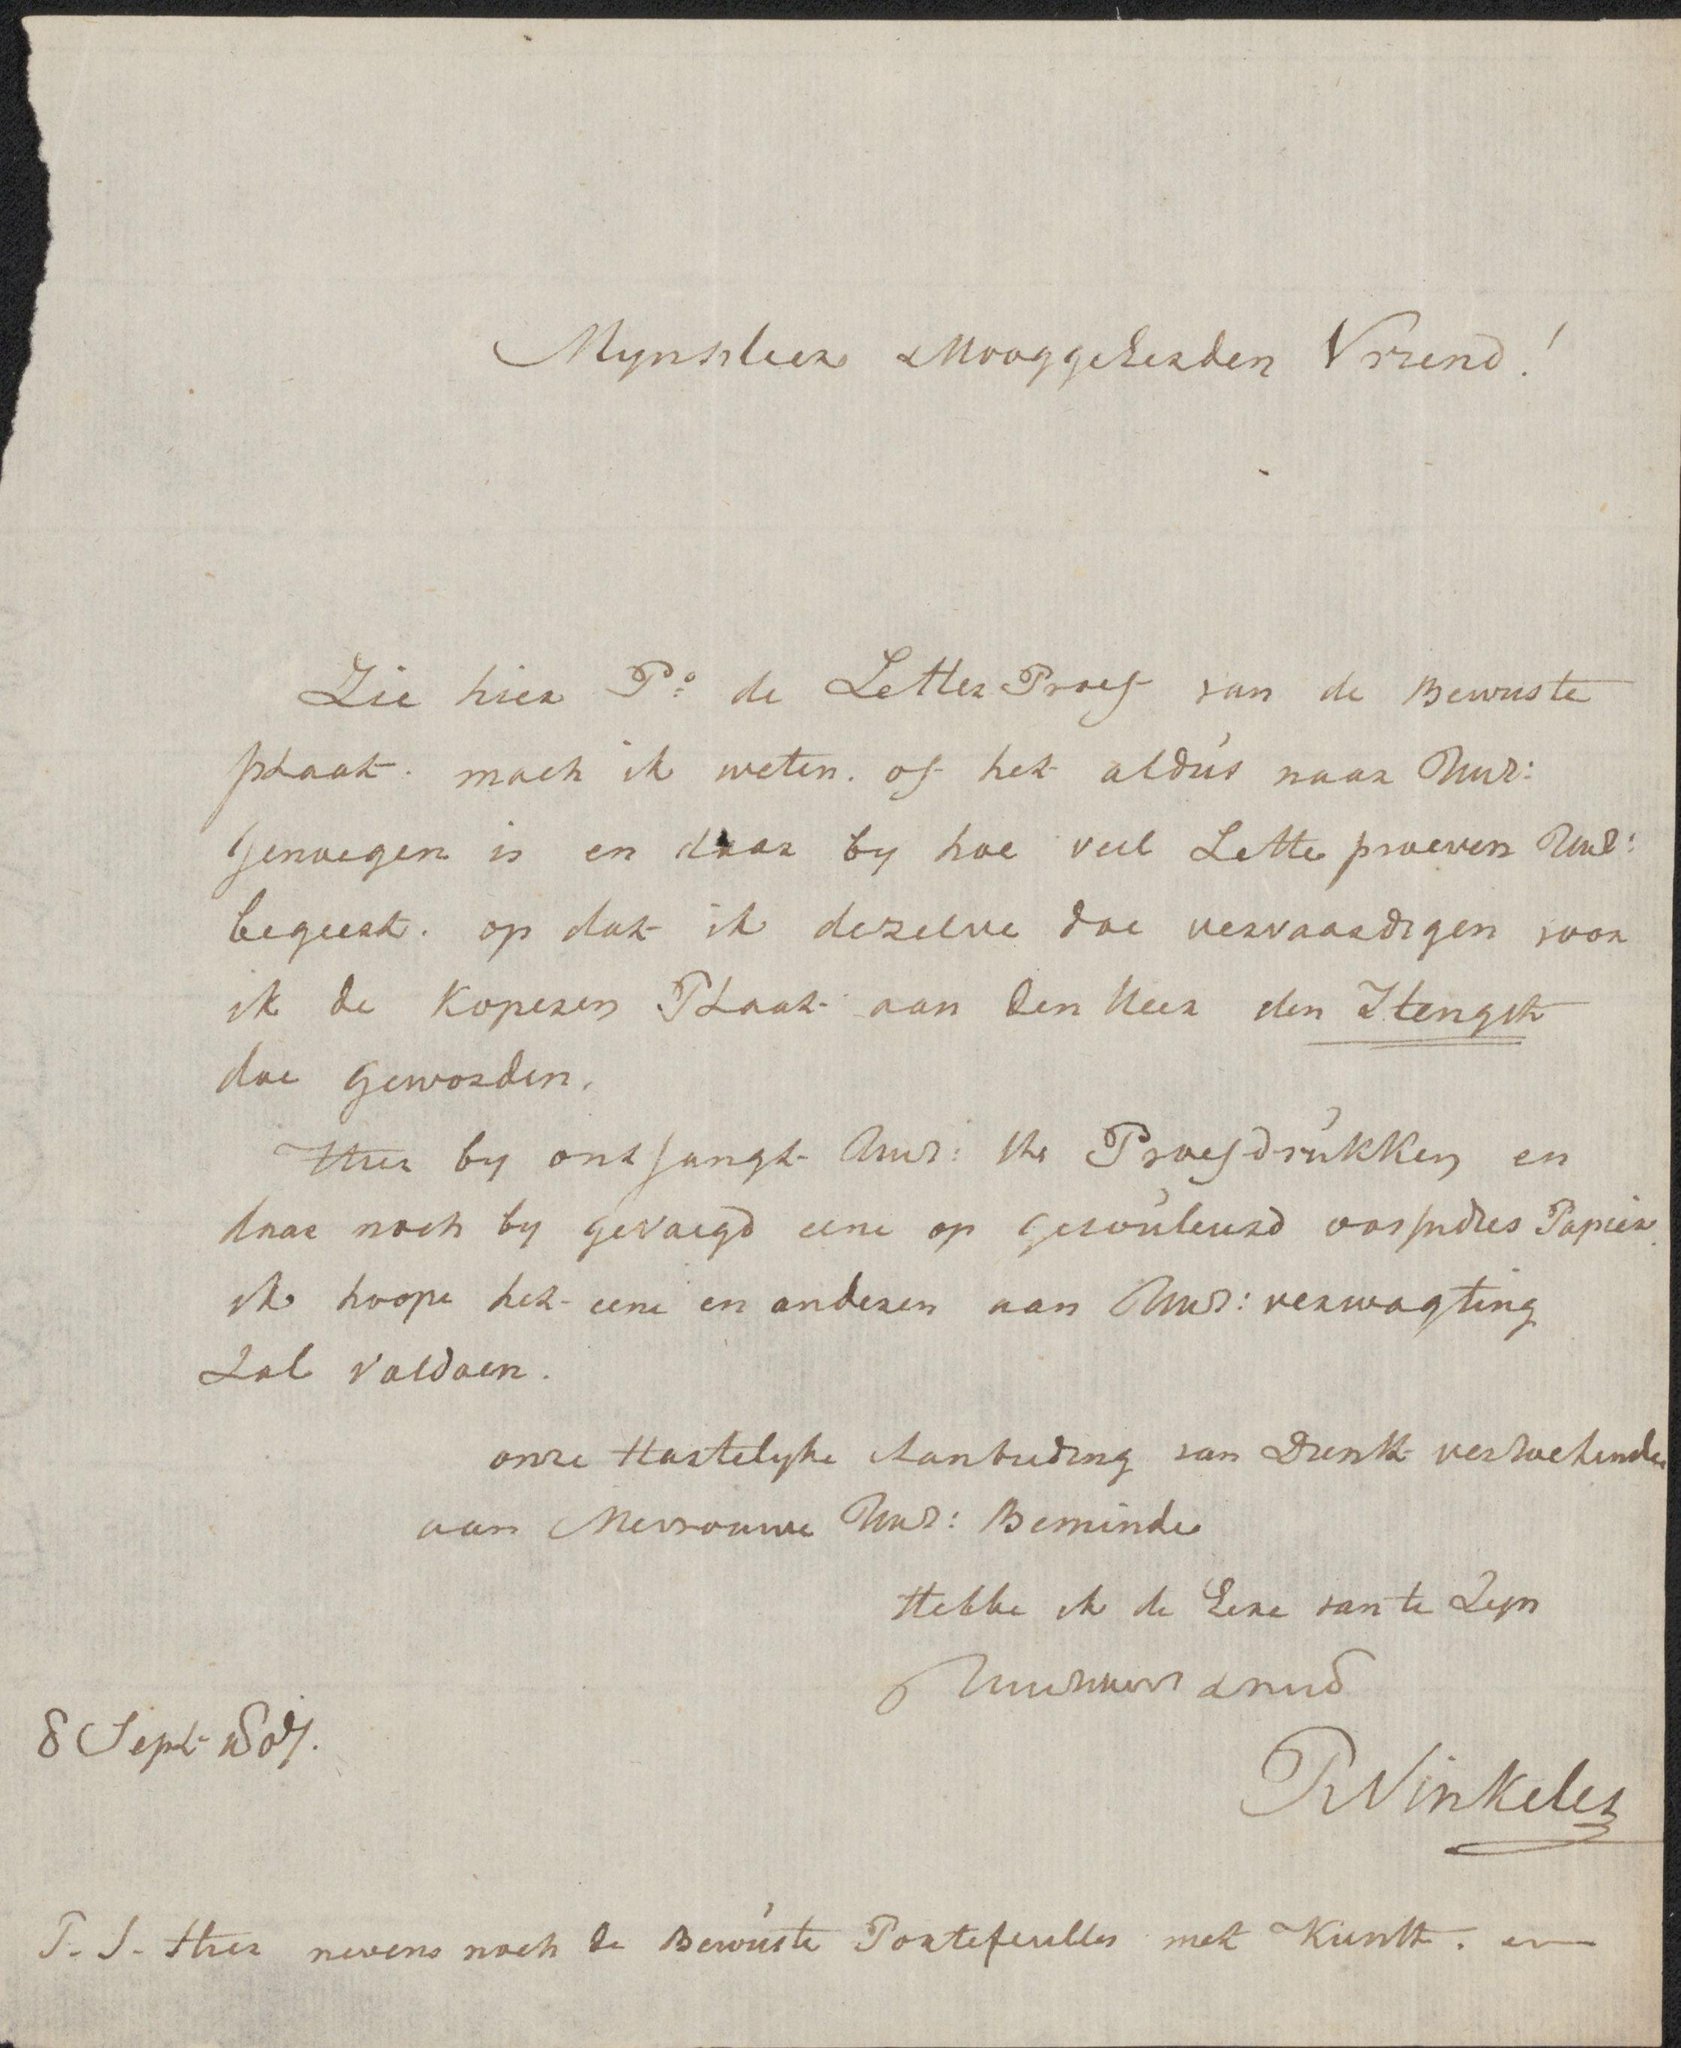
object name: letter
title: Brief aan anoniem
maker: reinier vinkeles (i)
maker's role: draughtsman, print maker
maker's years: 1741-1816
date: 1807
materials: ink, paper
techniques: pen, writing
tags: the graphic arts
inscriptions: watermark